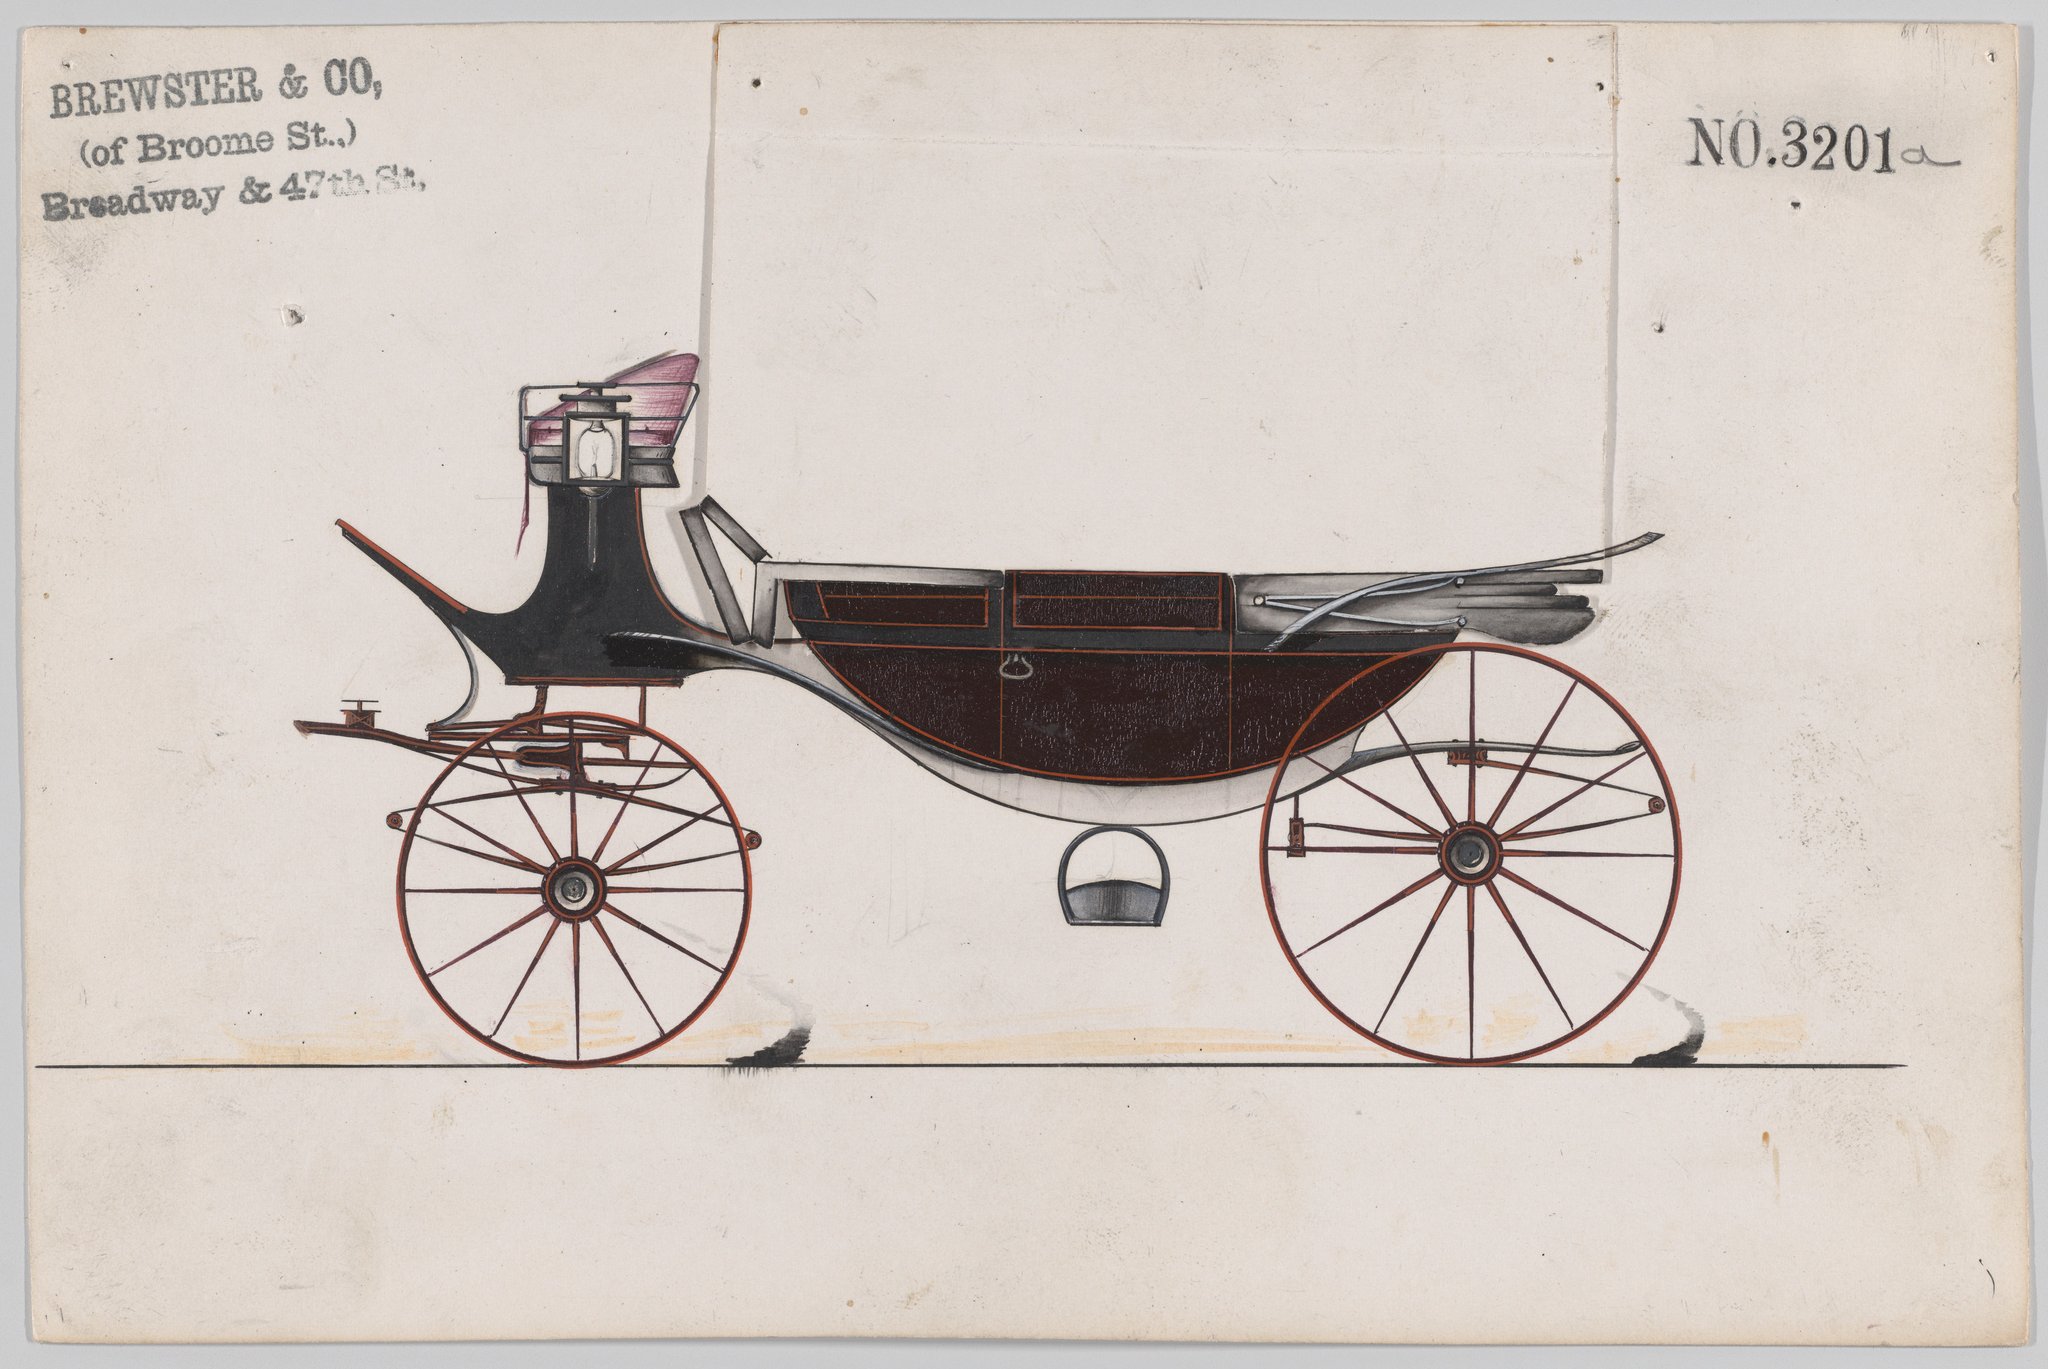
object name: drawing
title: Design for Landau, No. 3201a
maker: brewster & co.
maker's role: manufacturer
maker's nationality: american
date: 1876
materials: gouache, gum arabic, ink, watercolor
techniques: pen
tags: carriages